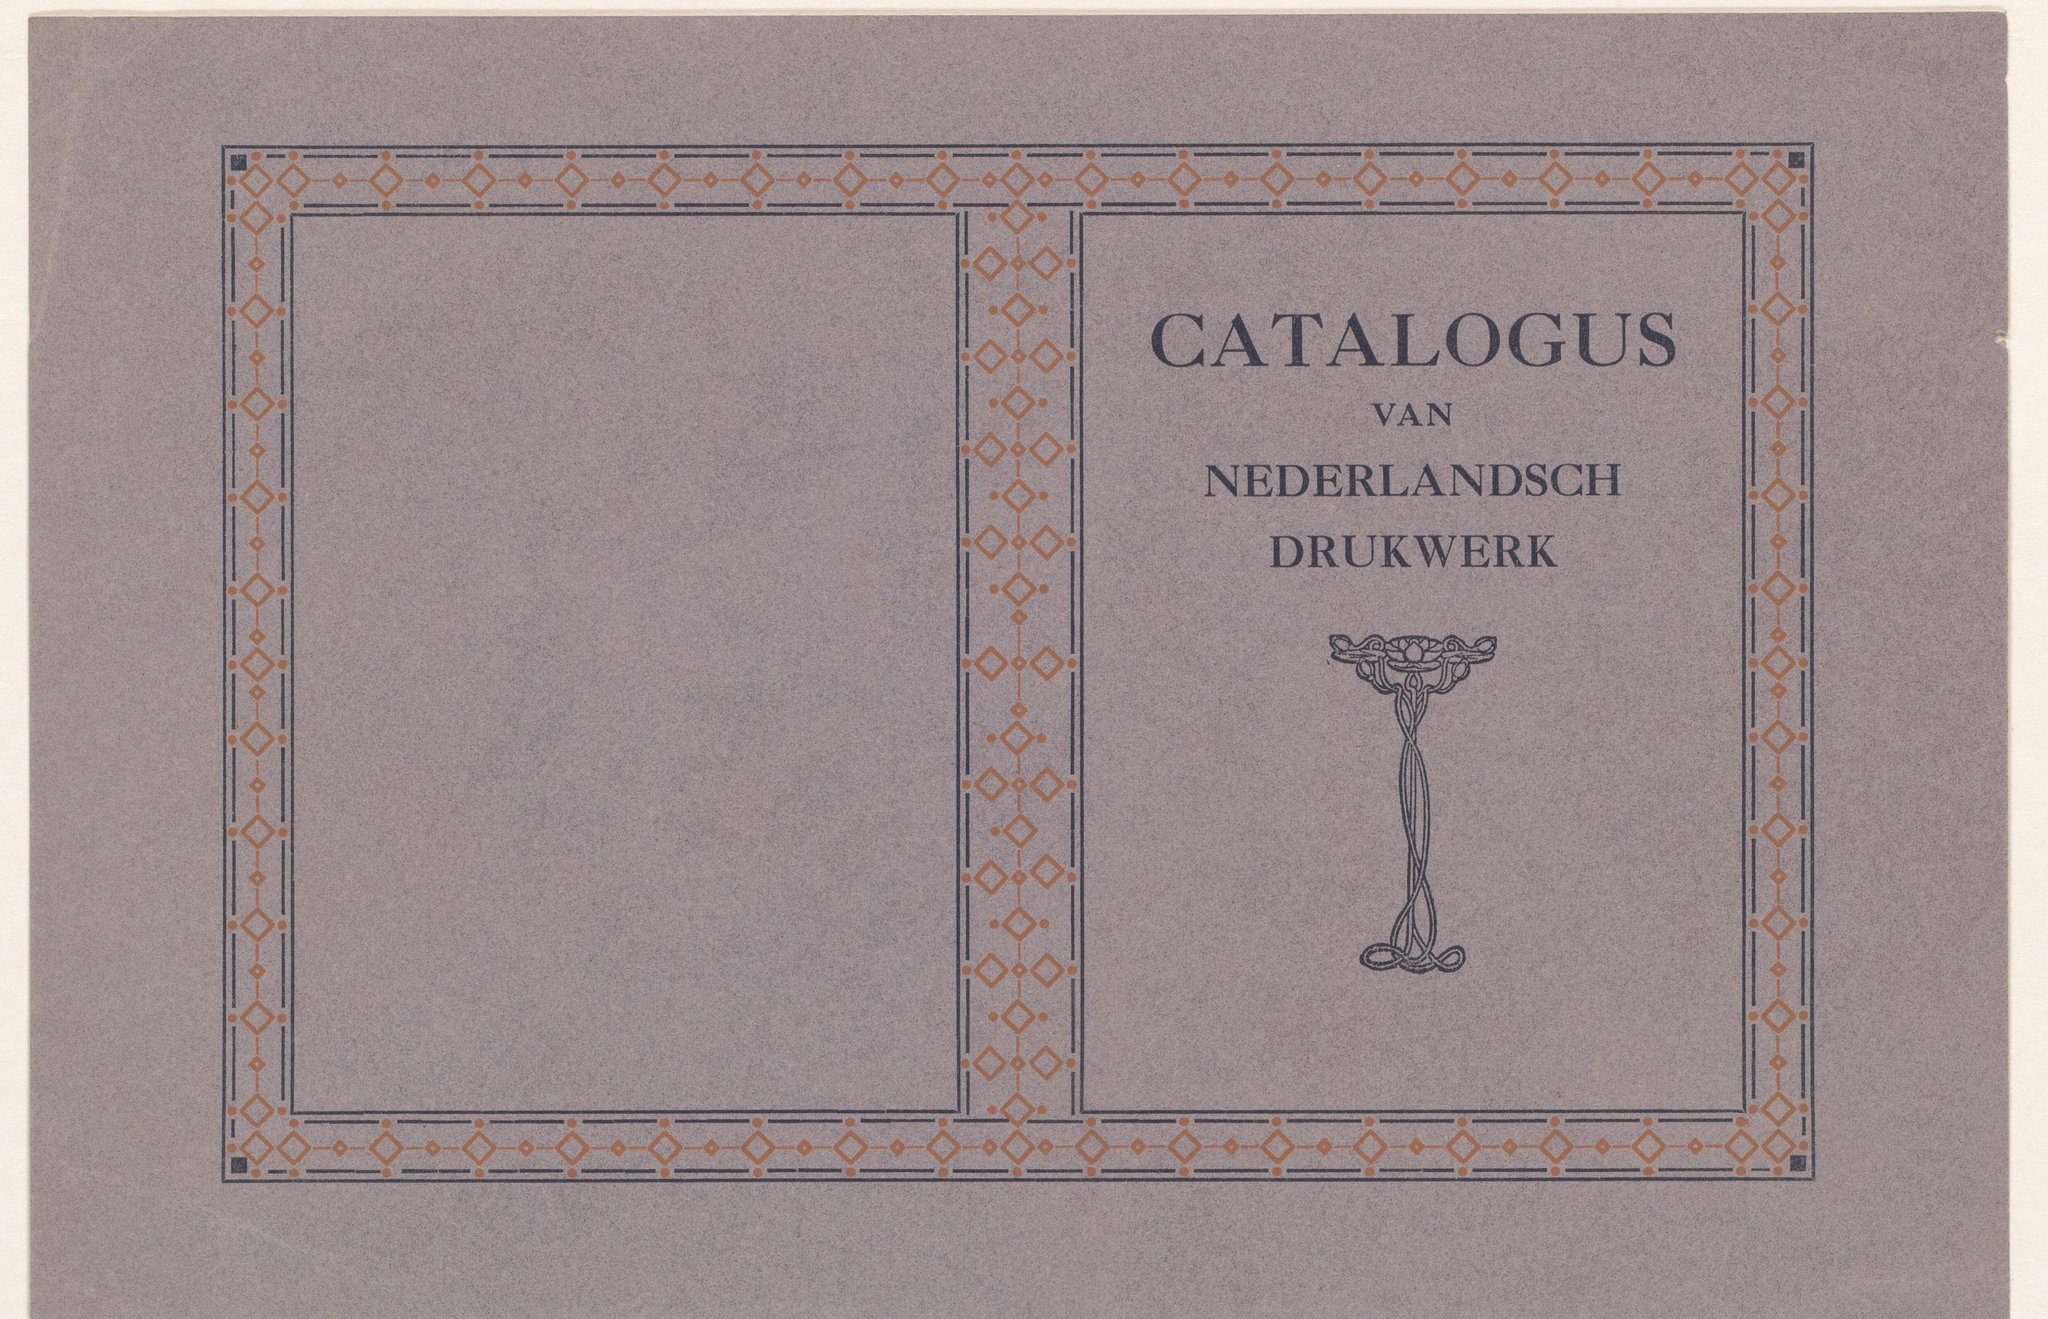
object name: photomechanical print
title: Omslagontwerp voor: Catalogus van Nederlandsch drukwerk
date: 1884-1952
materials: paper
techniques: printing block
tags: interlace ~ ornament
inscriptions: collector's mark: ‘R:MVS.’